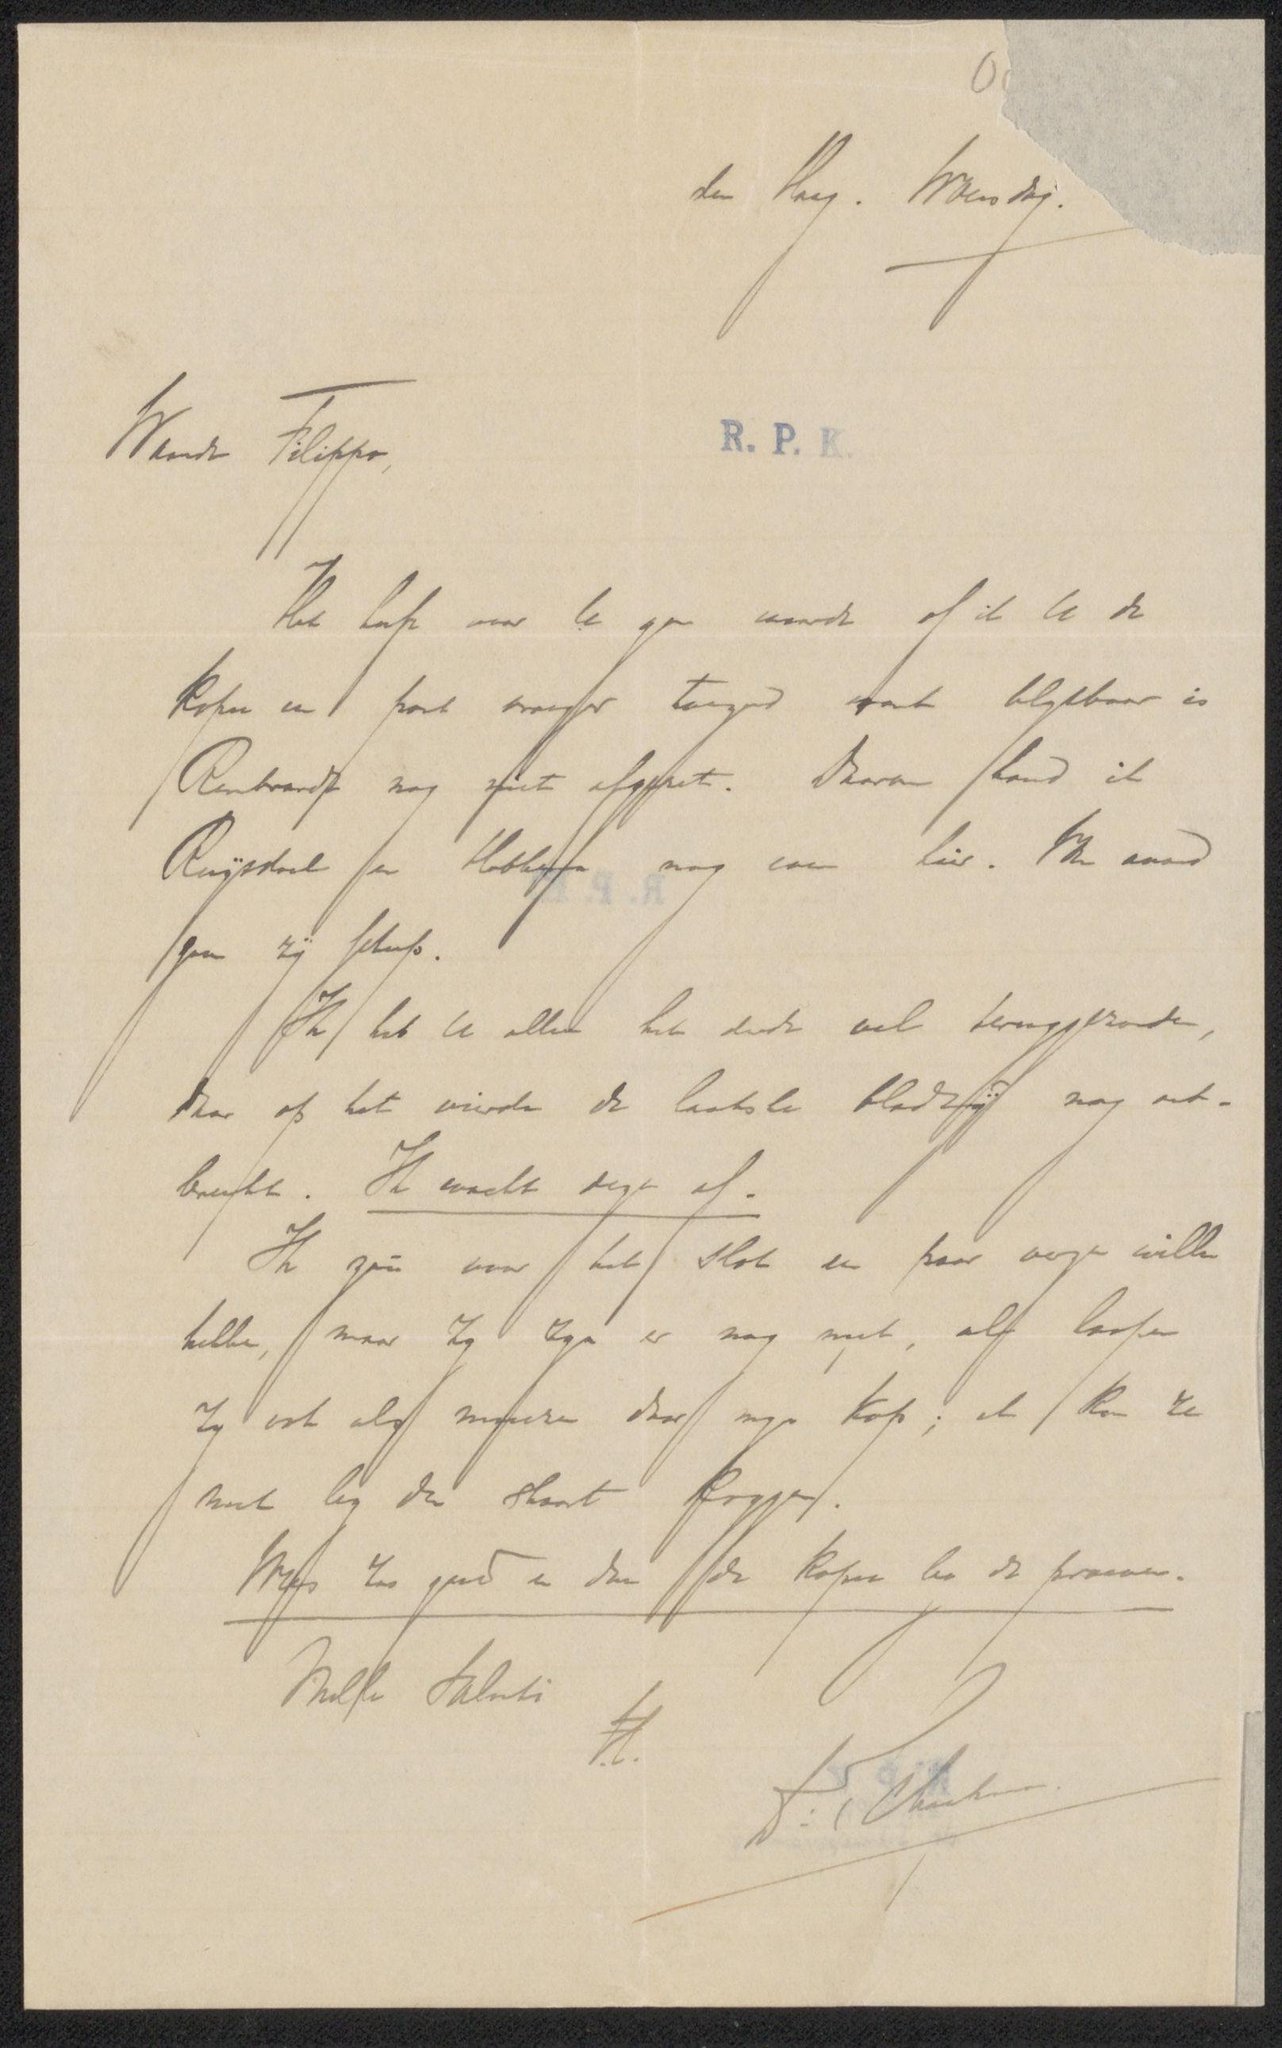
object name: letter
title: Brief aan Filippo Tessaro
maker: herman johannes aloysius maria schaepman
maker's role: priest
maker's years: 1844-1903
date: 1854-1903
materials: ink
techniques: pen, writing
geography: the hague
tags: meindert hobbema, leiden, rembrandt van rijn, haarlem, painter, print maker, draughtsman, jacob isaacksz van ruisdael, printed matter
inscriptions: collector's mark: Lugt 2233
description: Brief gedateerd oktober 1887 in latere hand.